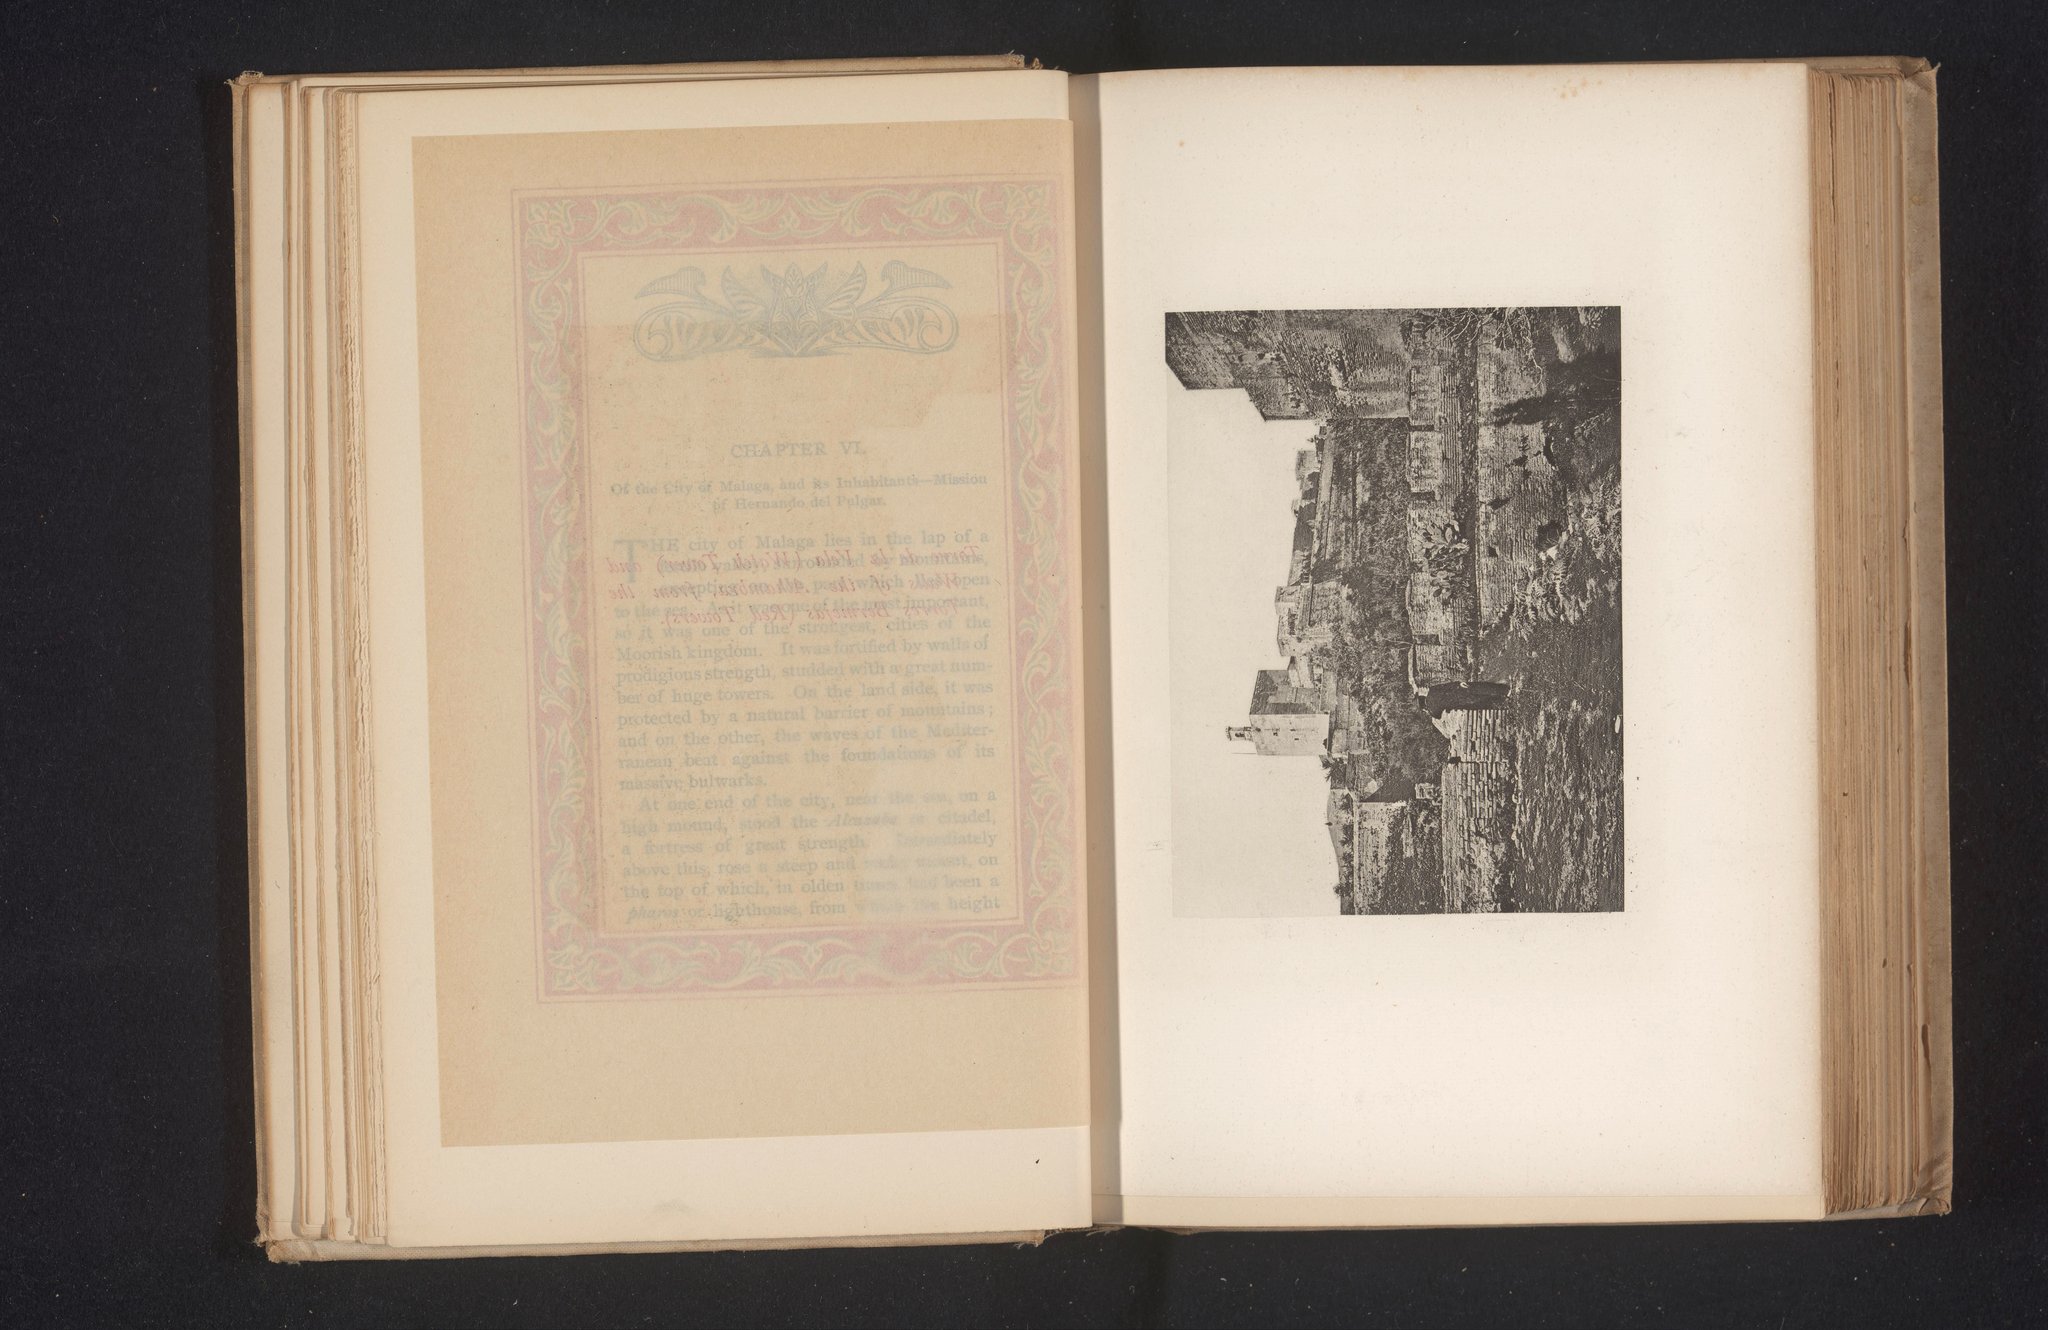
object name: page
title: Gezicht op de Torre de la Vela en de muren van het Alhambra in Granada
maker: Anonymous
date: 1883-1893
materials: paper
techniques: photoaquatint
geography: granada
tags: tower, clock tower ~ monumental adornment